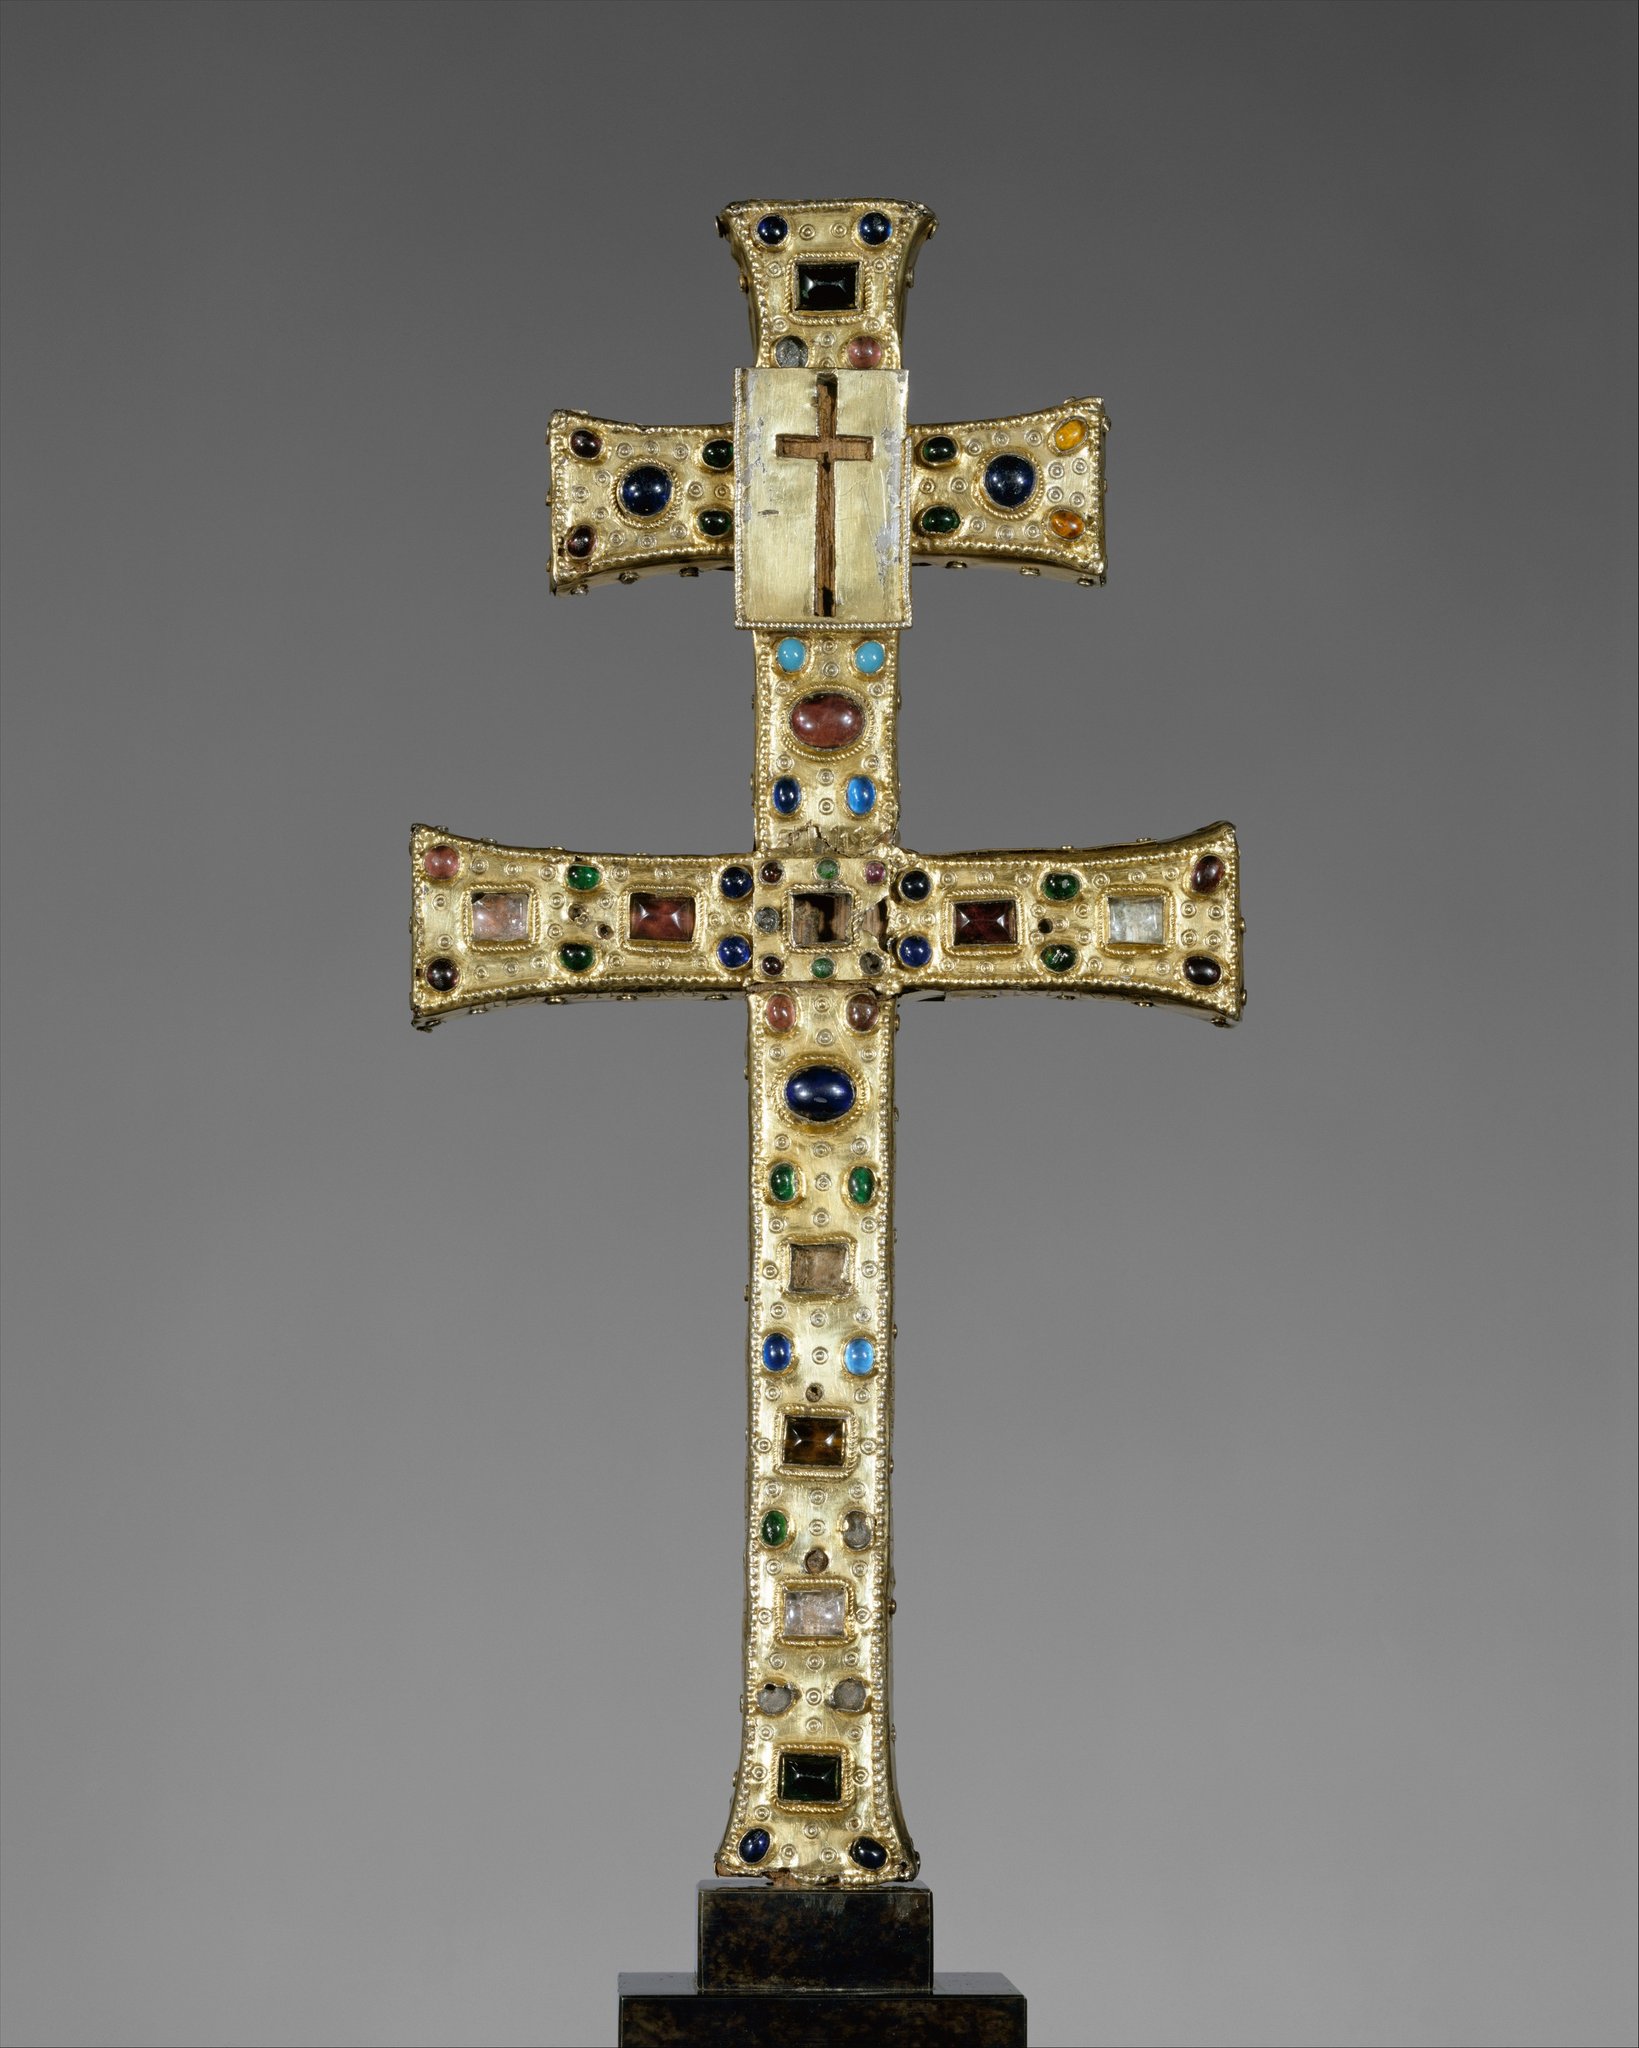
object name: reliquary cross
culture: french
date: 1180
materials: glass, quartz, silver gilt, wood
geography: france